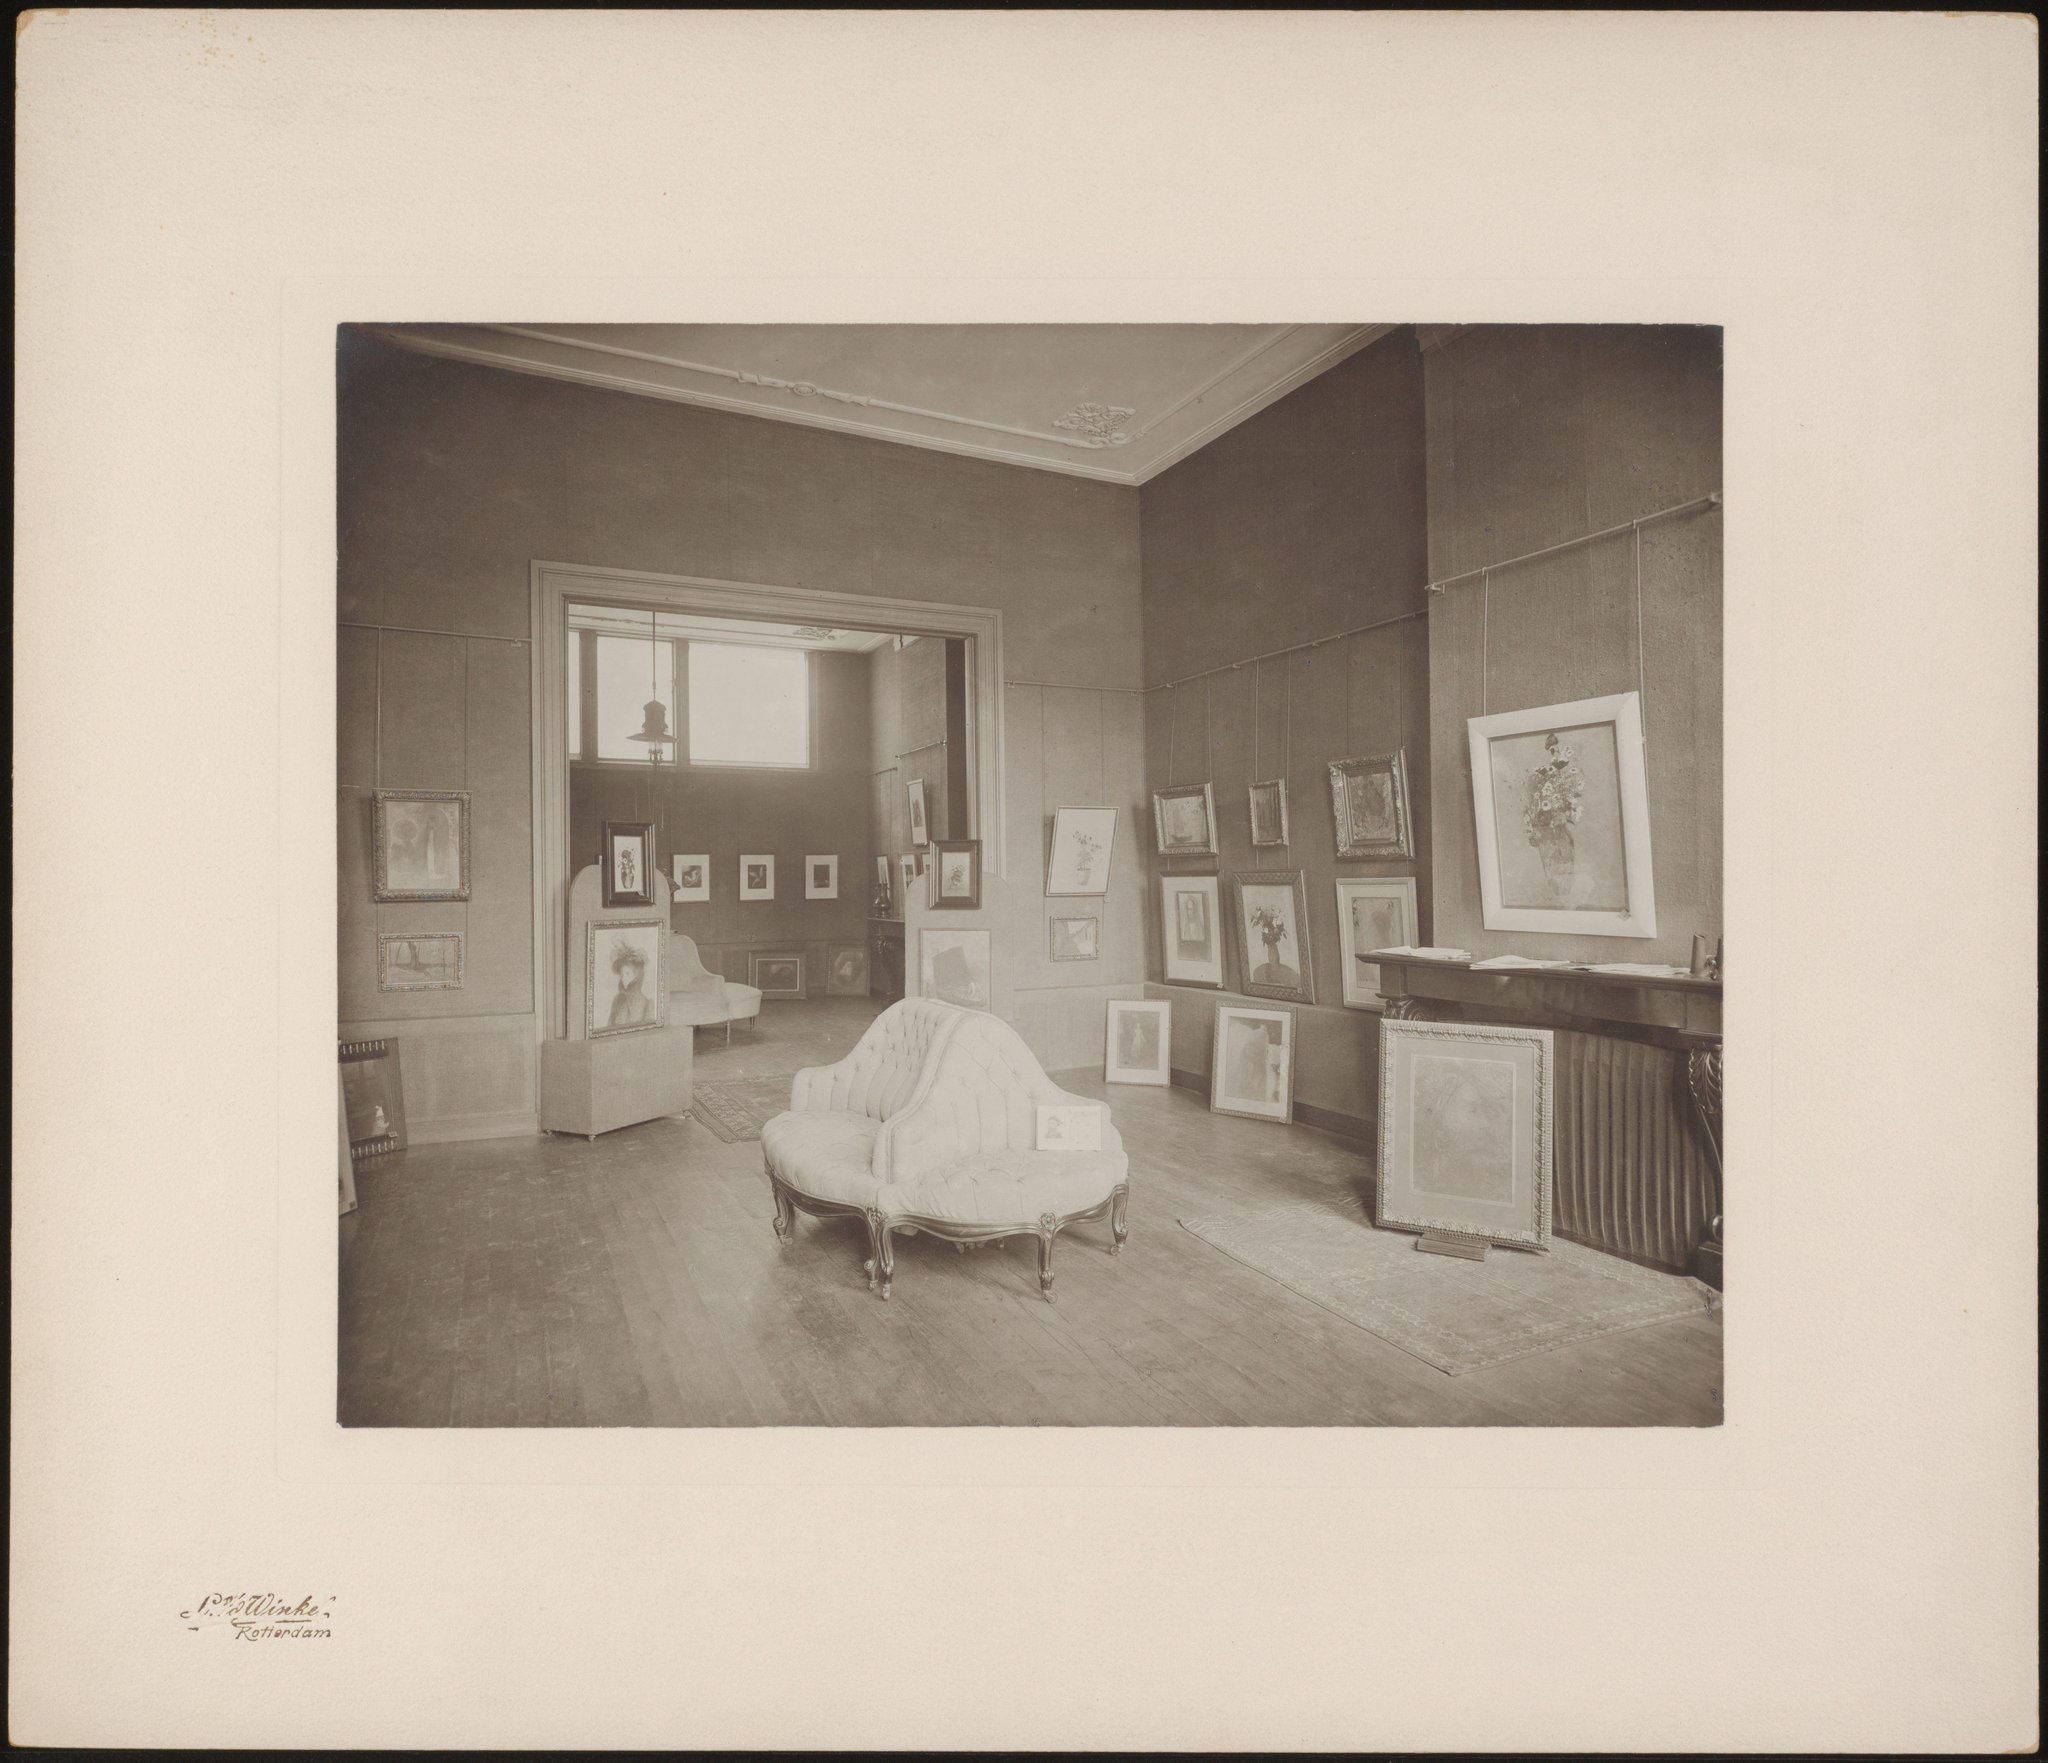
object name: photograph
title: Interieur van kunsthandel Reckers tijdens de Redon-expositie van 1907, Rotterdam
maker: lodewijk van de winkel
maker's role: fotograaf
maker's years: 1856-1919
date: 1905-1907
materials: cardboard, paper, photographic support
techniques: gelatin silver print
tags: exhibition ~ art